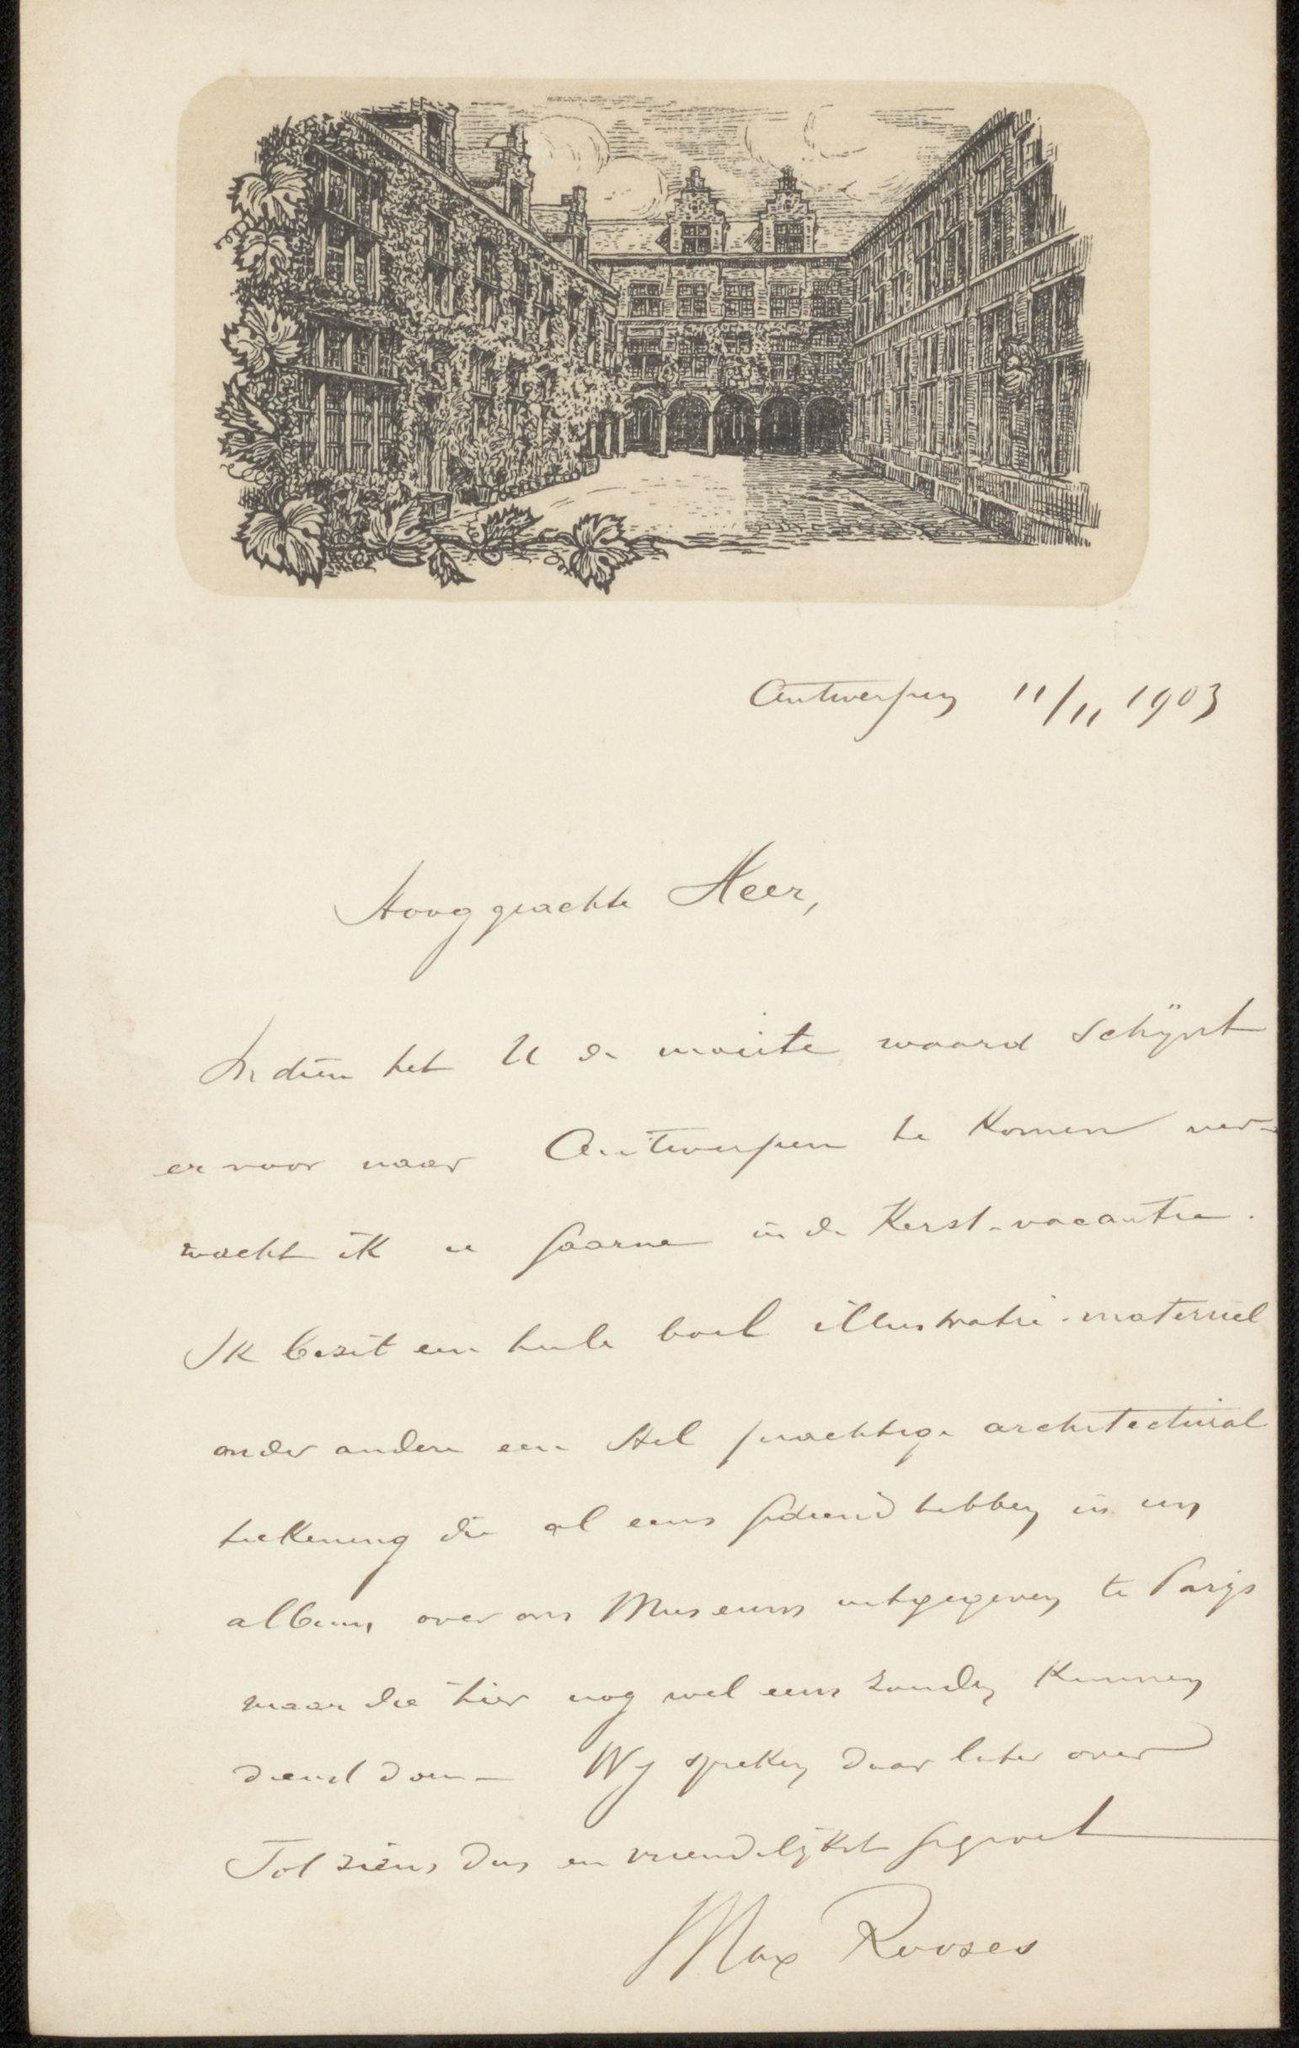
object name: letter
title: Brief aan Philip Zilcken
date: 1903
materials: ink, paper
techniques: pen, printing, writing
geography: antwerp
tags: the hague, painter, philip zilcken, the graphic arts, illustration ~ printed matter, book, architecture, antwerp, paris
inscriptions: watermark, collector's mark: ‘RPK’